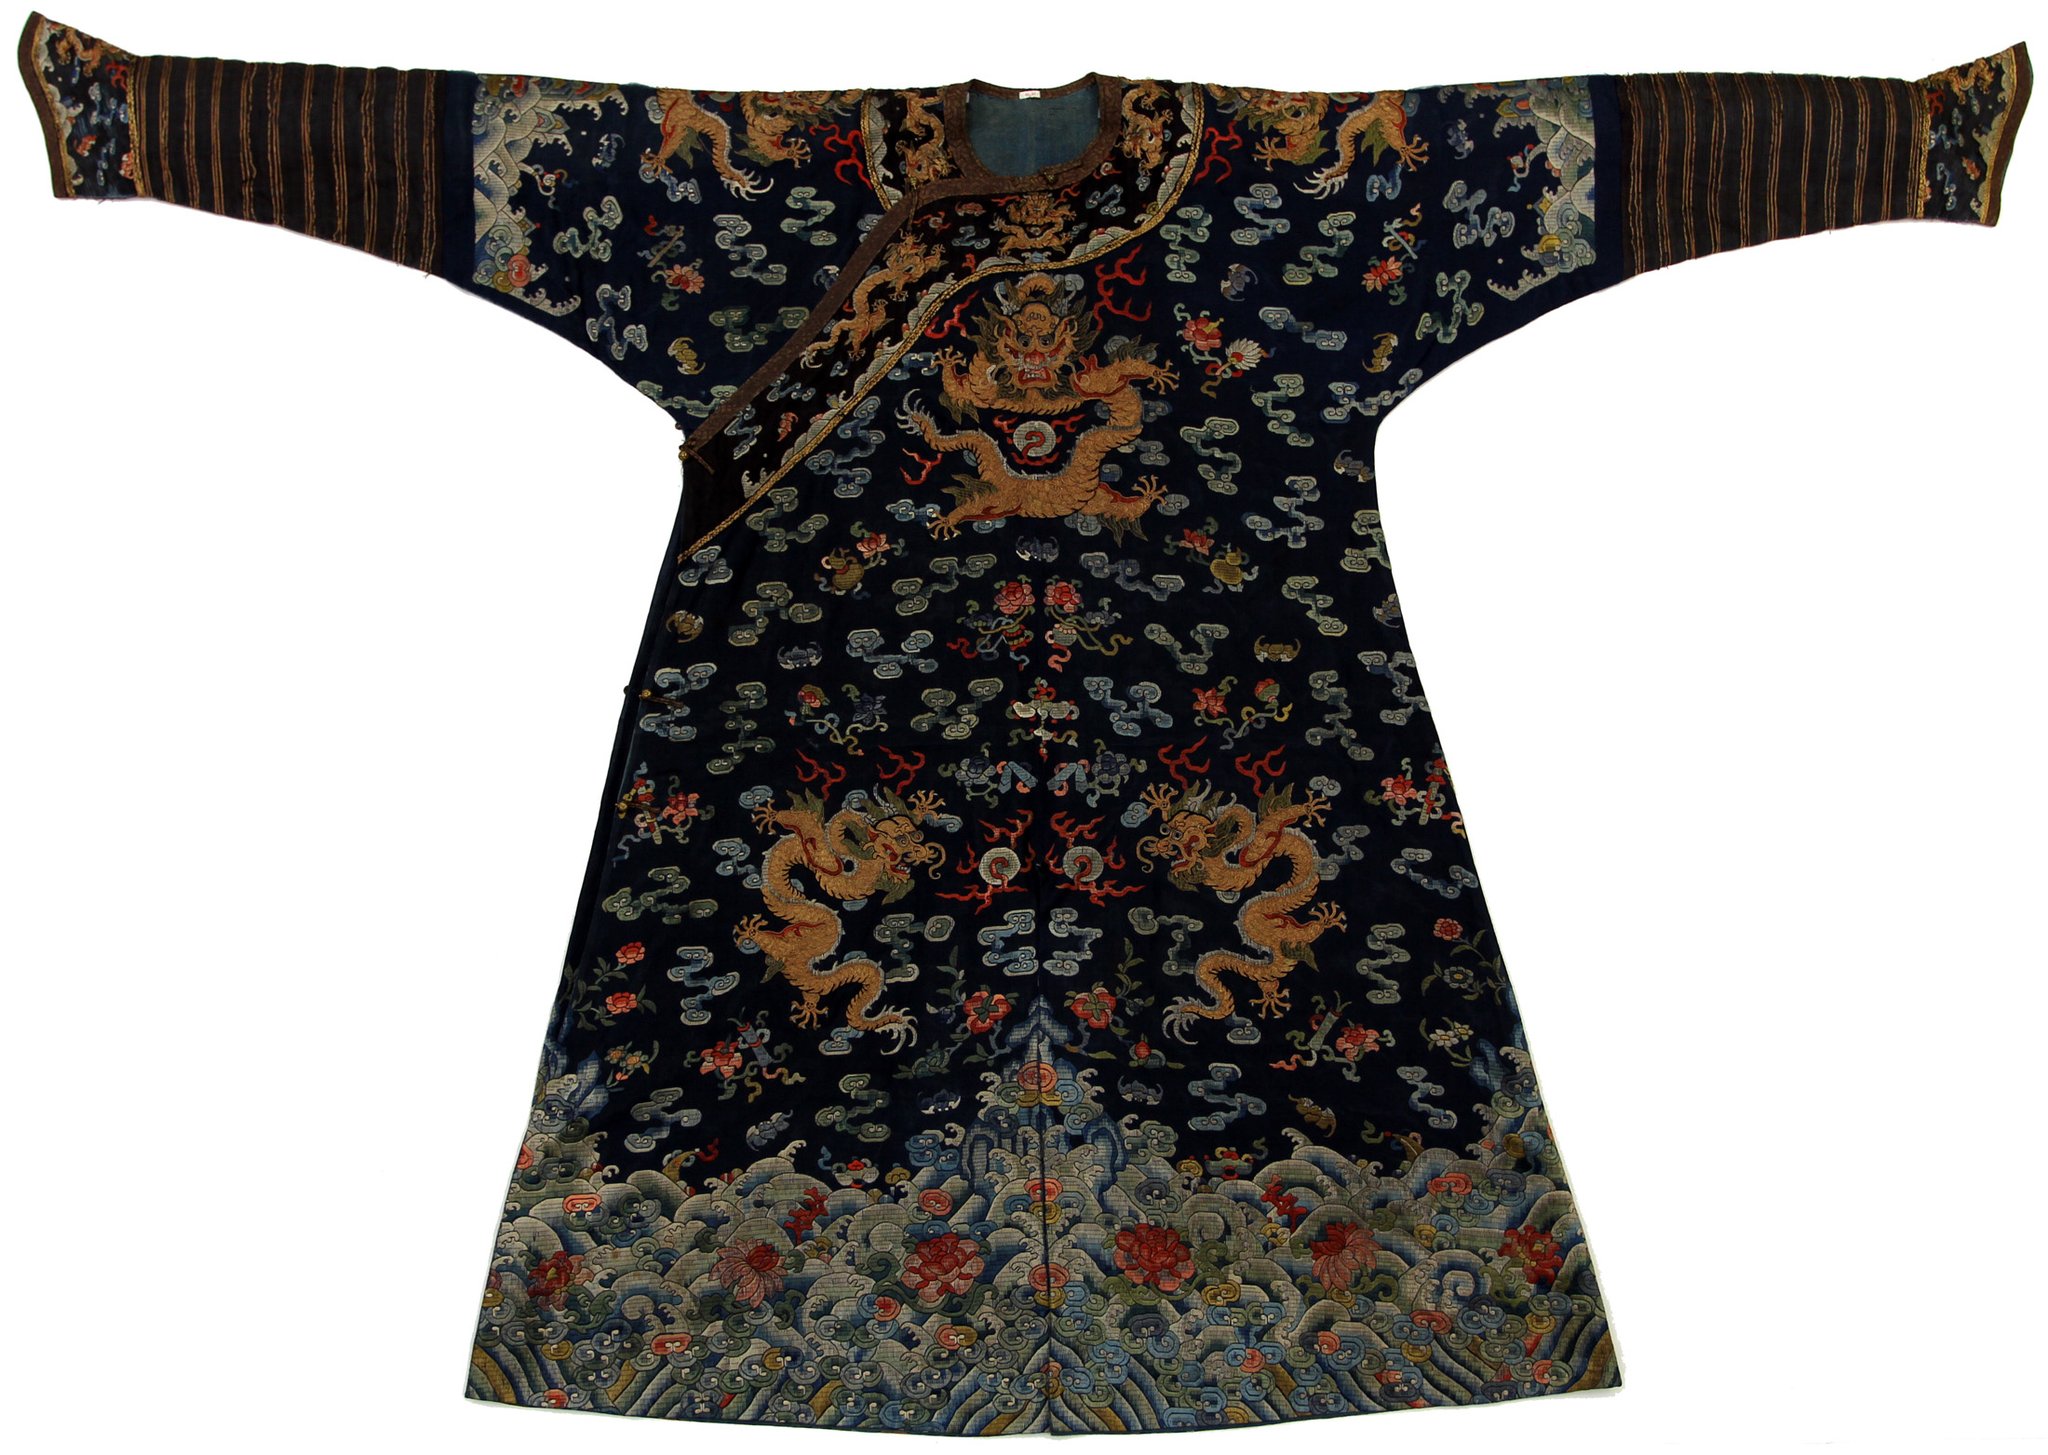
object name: robe, imperial court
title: Imperial Court Robe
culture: chinese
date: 1801-1850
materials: metal thread, silk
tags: dragons,flowers